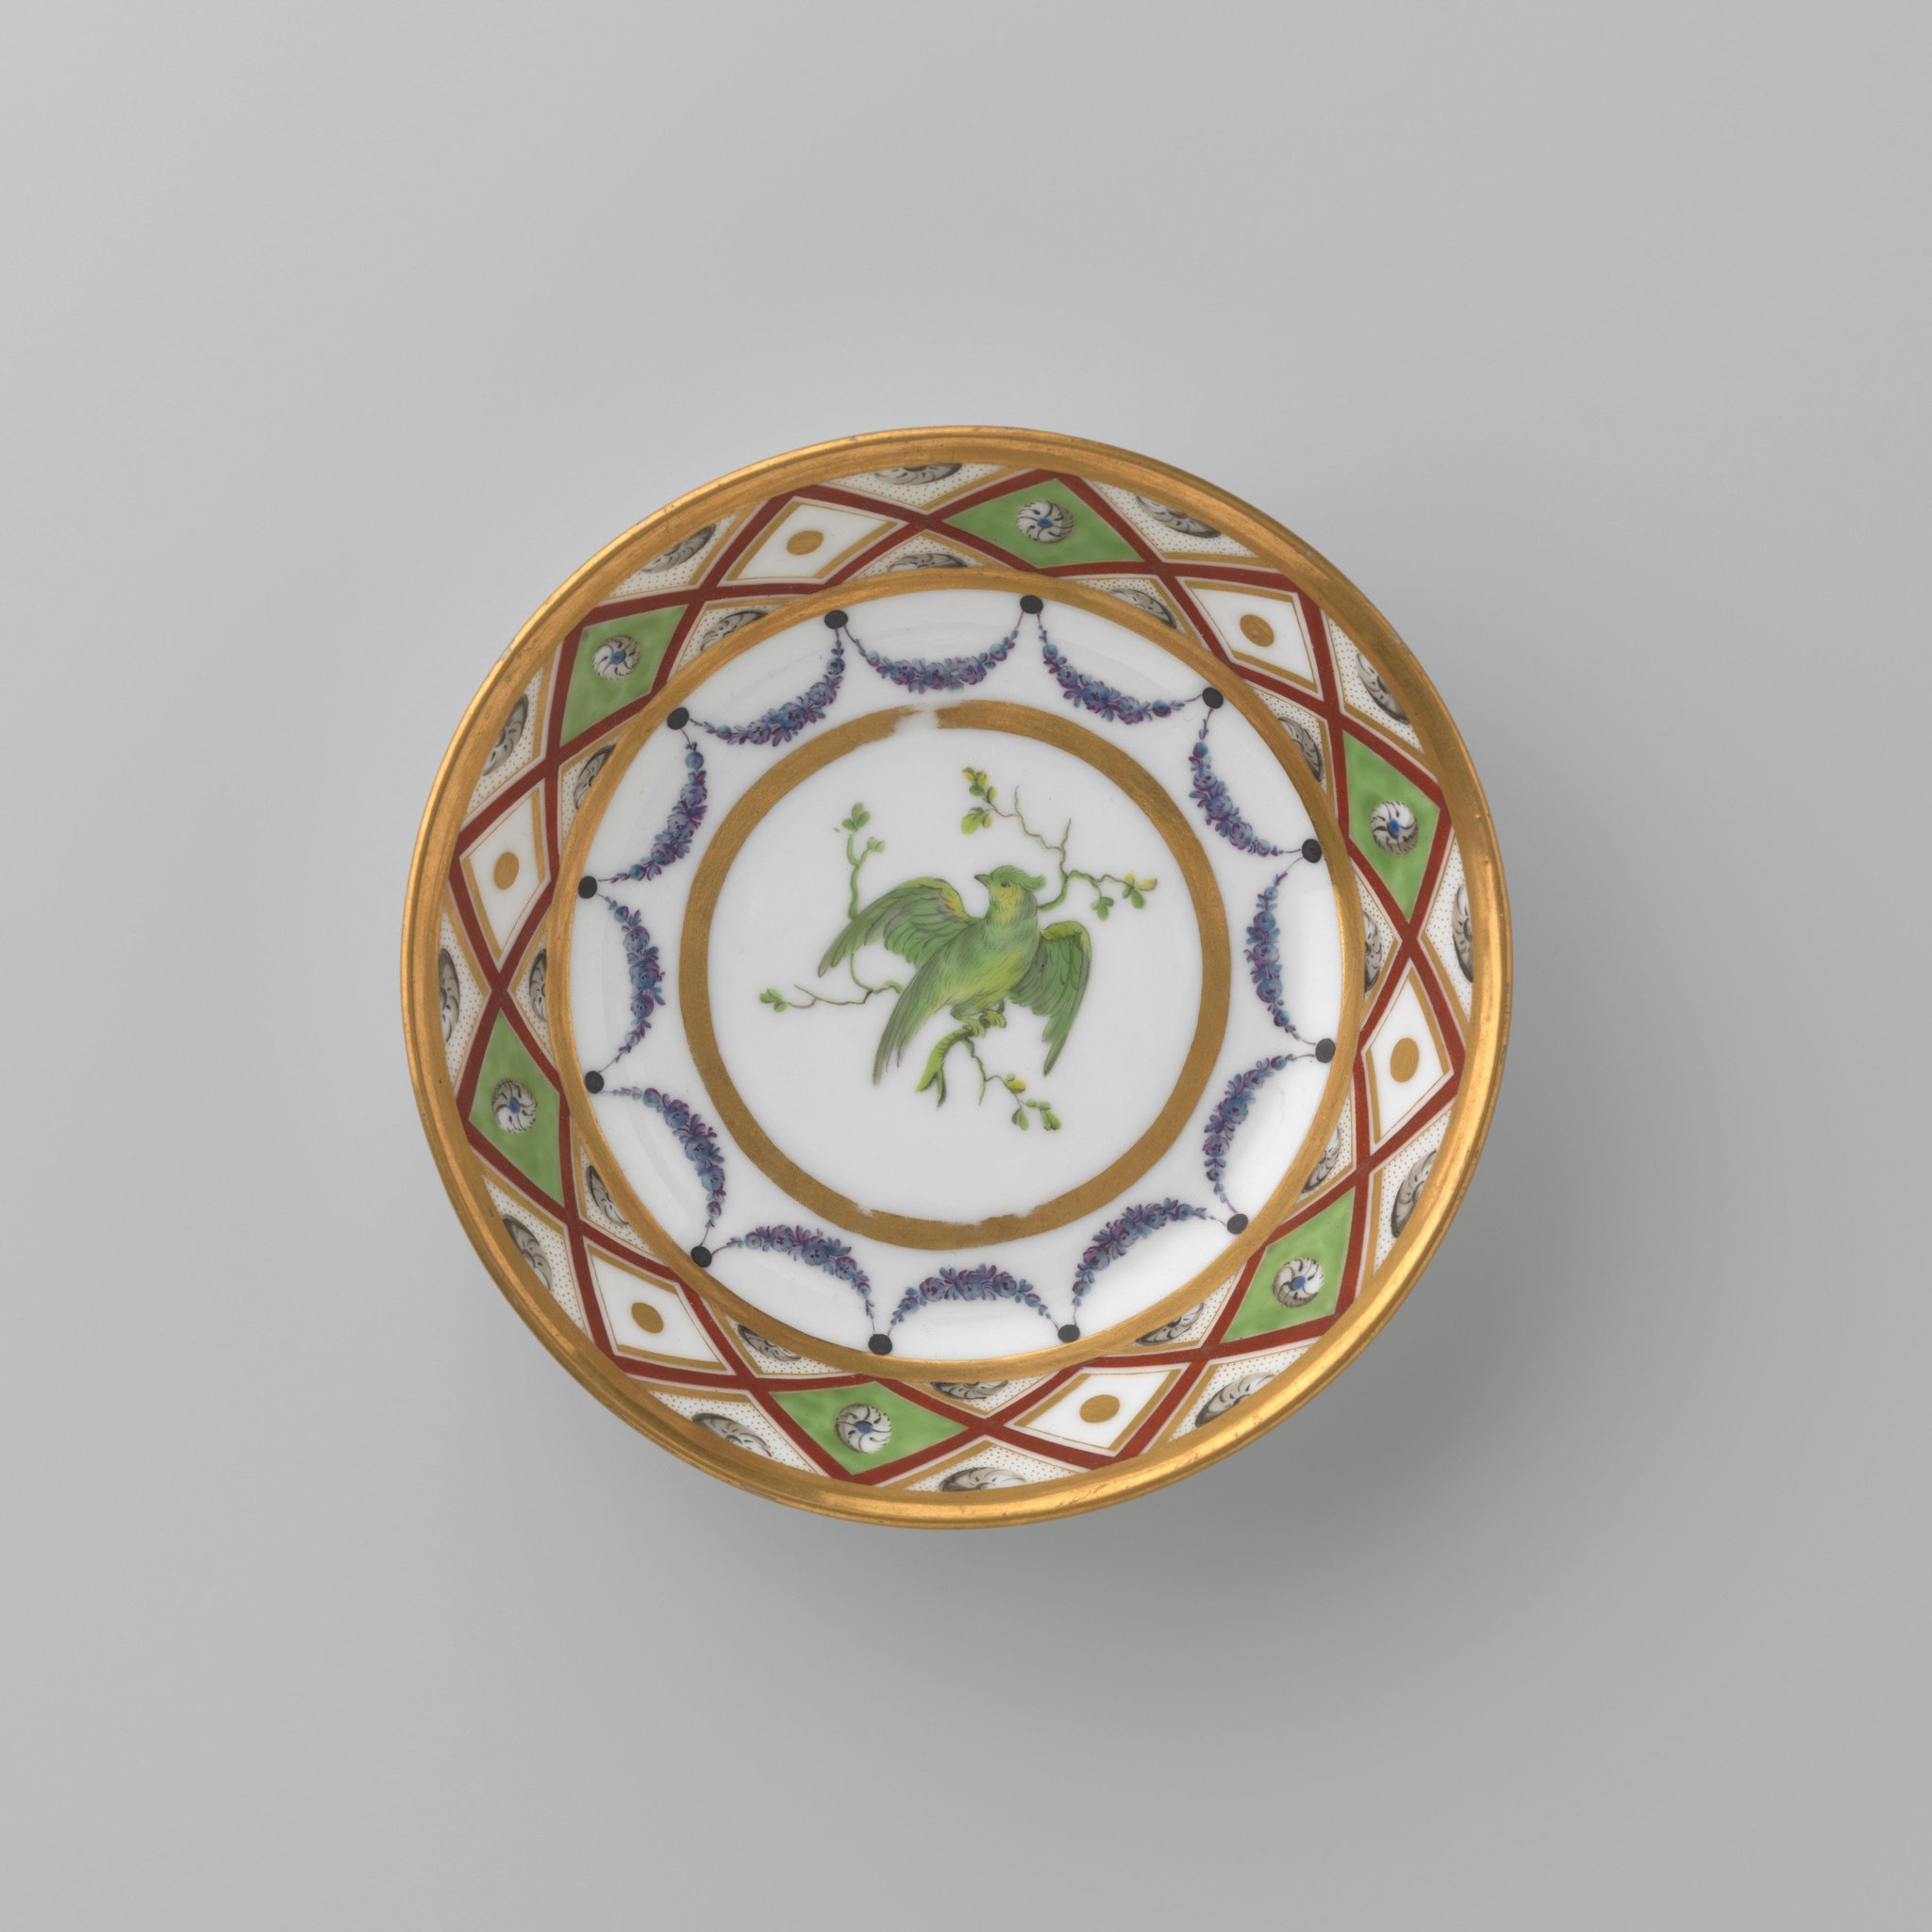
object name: platter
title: Saucer with a bird on a branch, lozenges and garlands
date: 1790-1820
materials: glaze, gold, paint, porcelain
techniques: firing, forming, gilding, turning, vitrification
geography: paris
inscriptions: mark: ‘gekruiste pijlen’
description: Schotel van porselein met een rechte wand, beschilderd op het glazuur in blauw, rood, groen, geel, paars, zwart en goud. Op het plat een gouden medaillon met een vogel op een tak. Hieromheen een band met guirlandes. Op de binnenwand rozetten in een ruitpatroon. Gouden rand. Gemerkt op de onderzijde met de gekruiste pijlen.